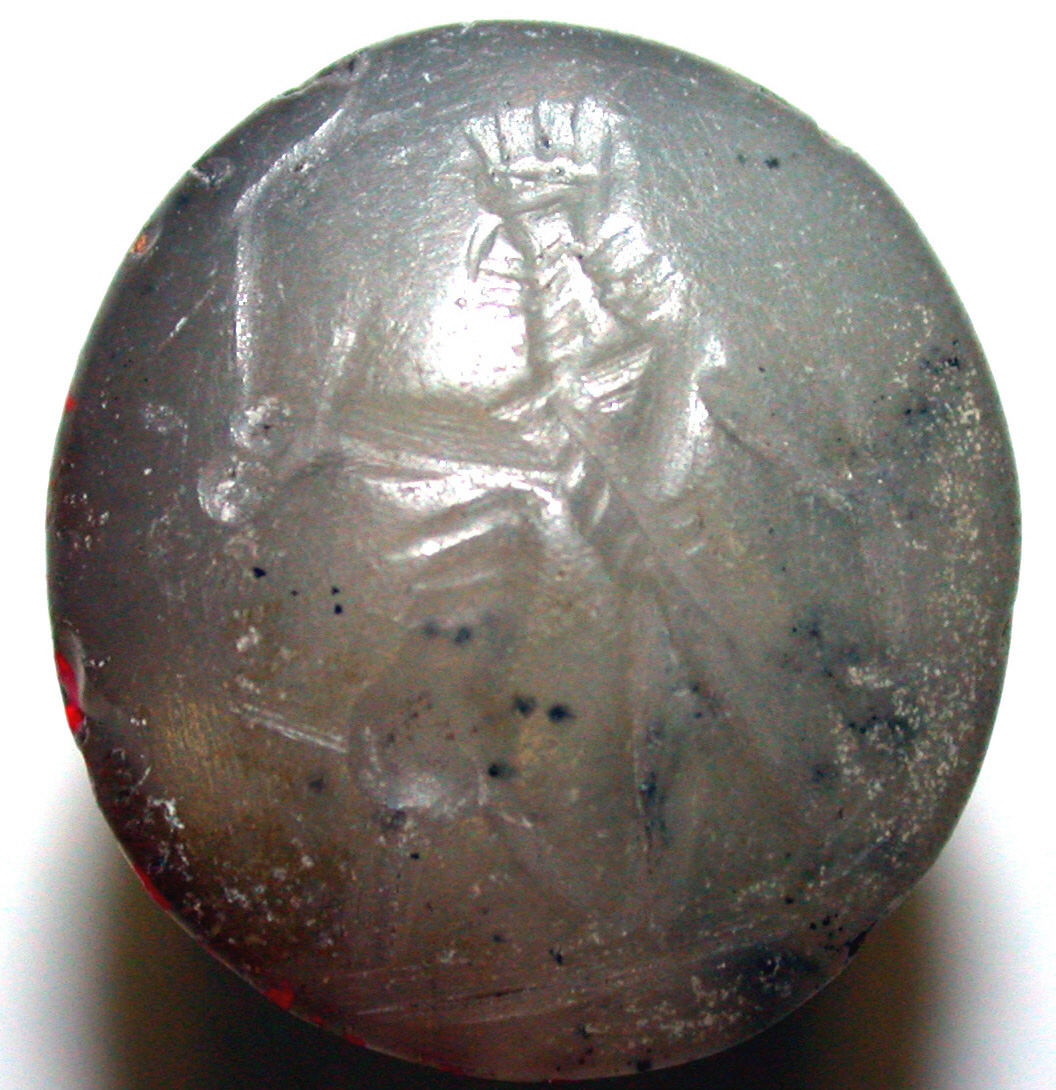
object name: stamp seal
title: Conical seal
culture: achaemenid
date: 600-401 BCE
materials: stone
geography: iran